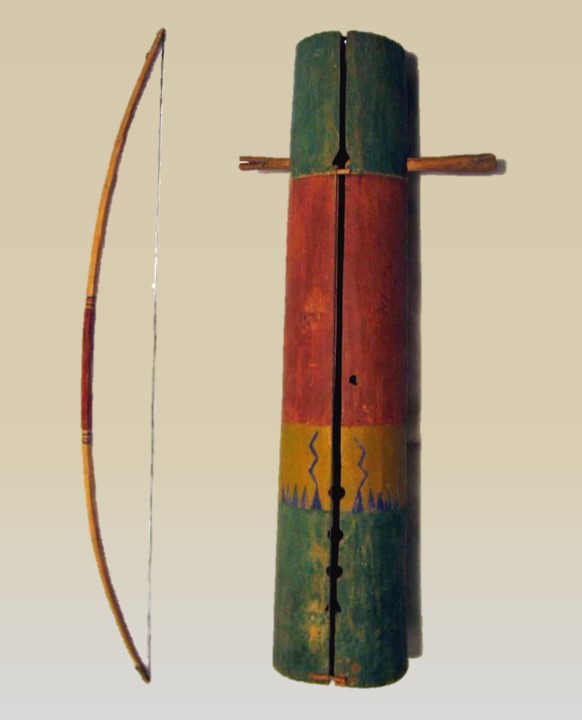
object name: tsii' edo' ai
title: Tsii' Edo' Ai (Apache Fiddle)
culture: native american, apache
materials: hair, wood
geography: united states